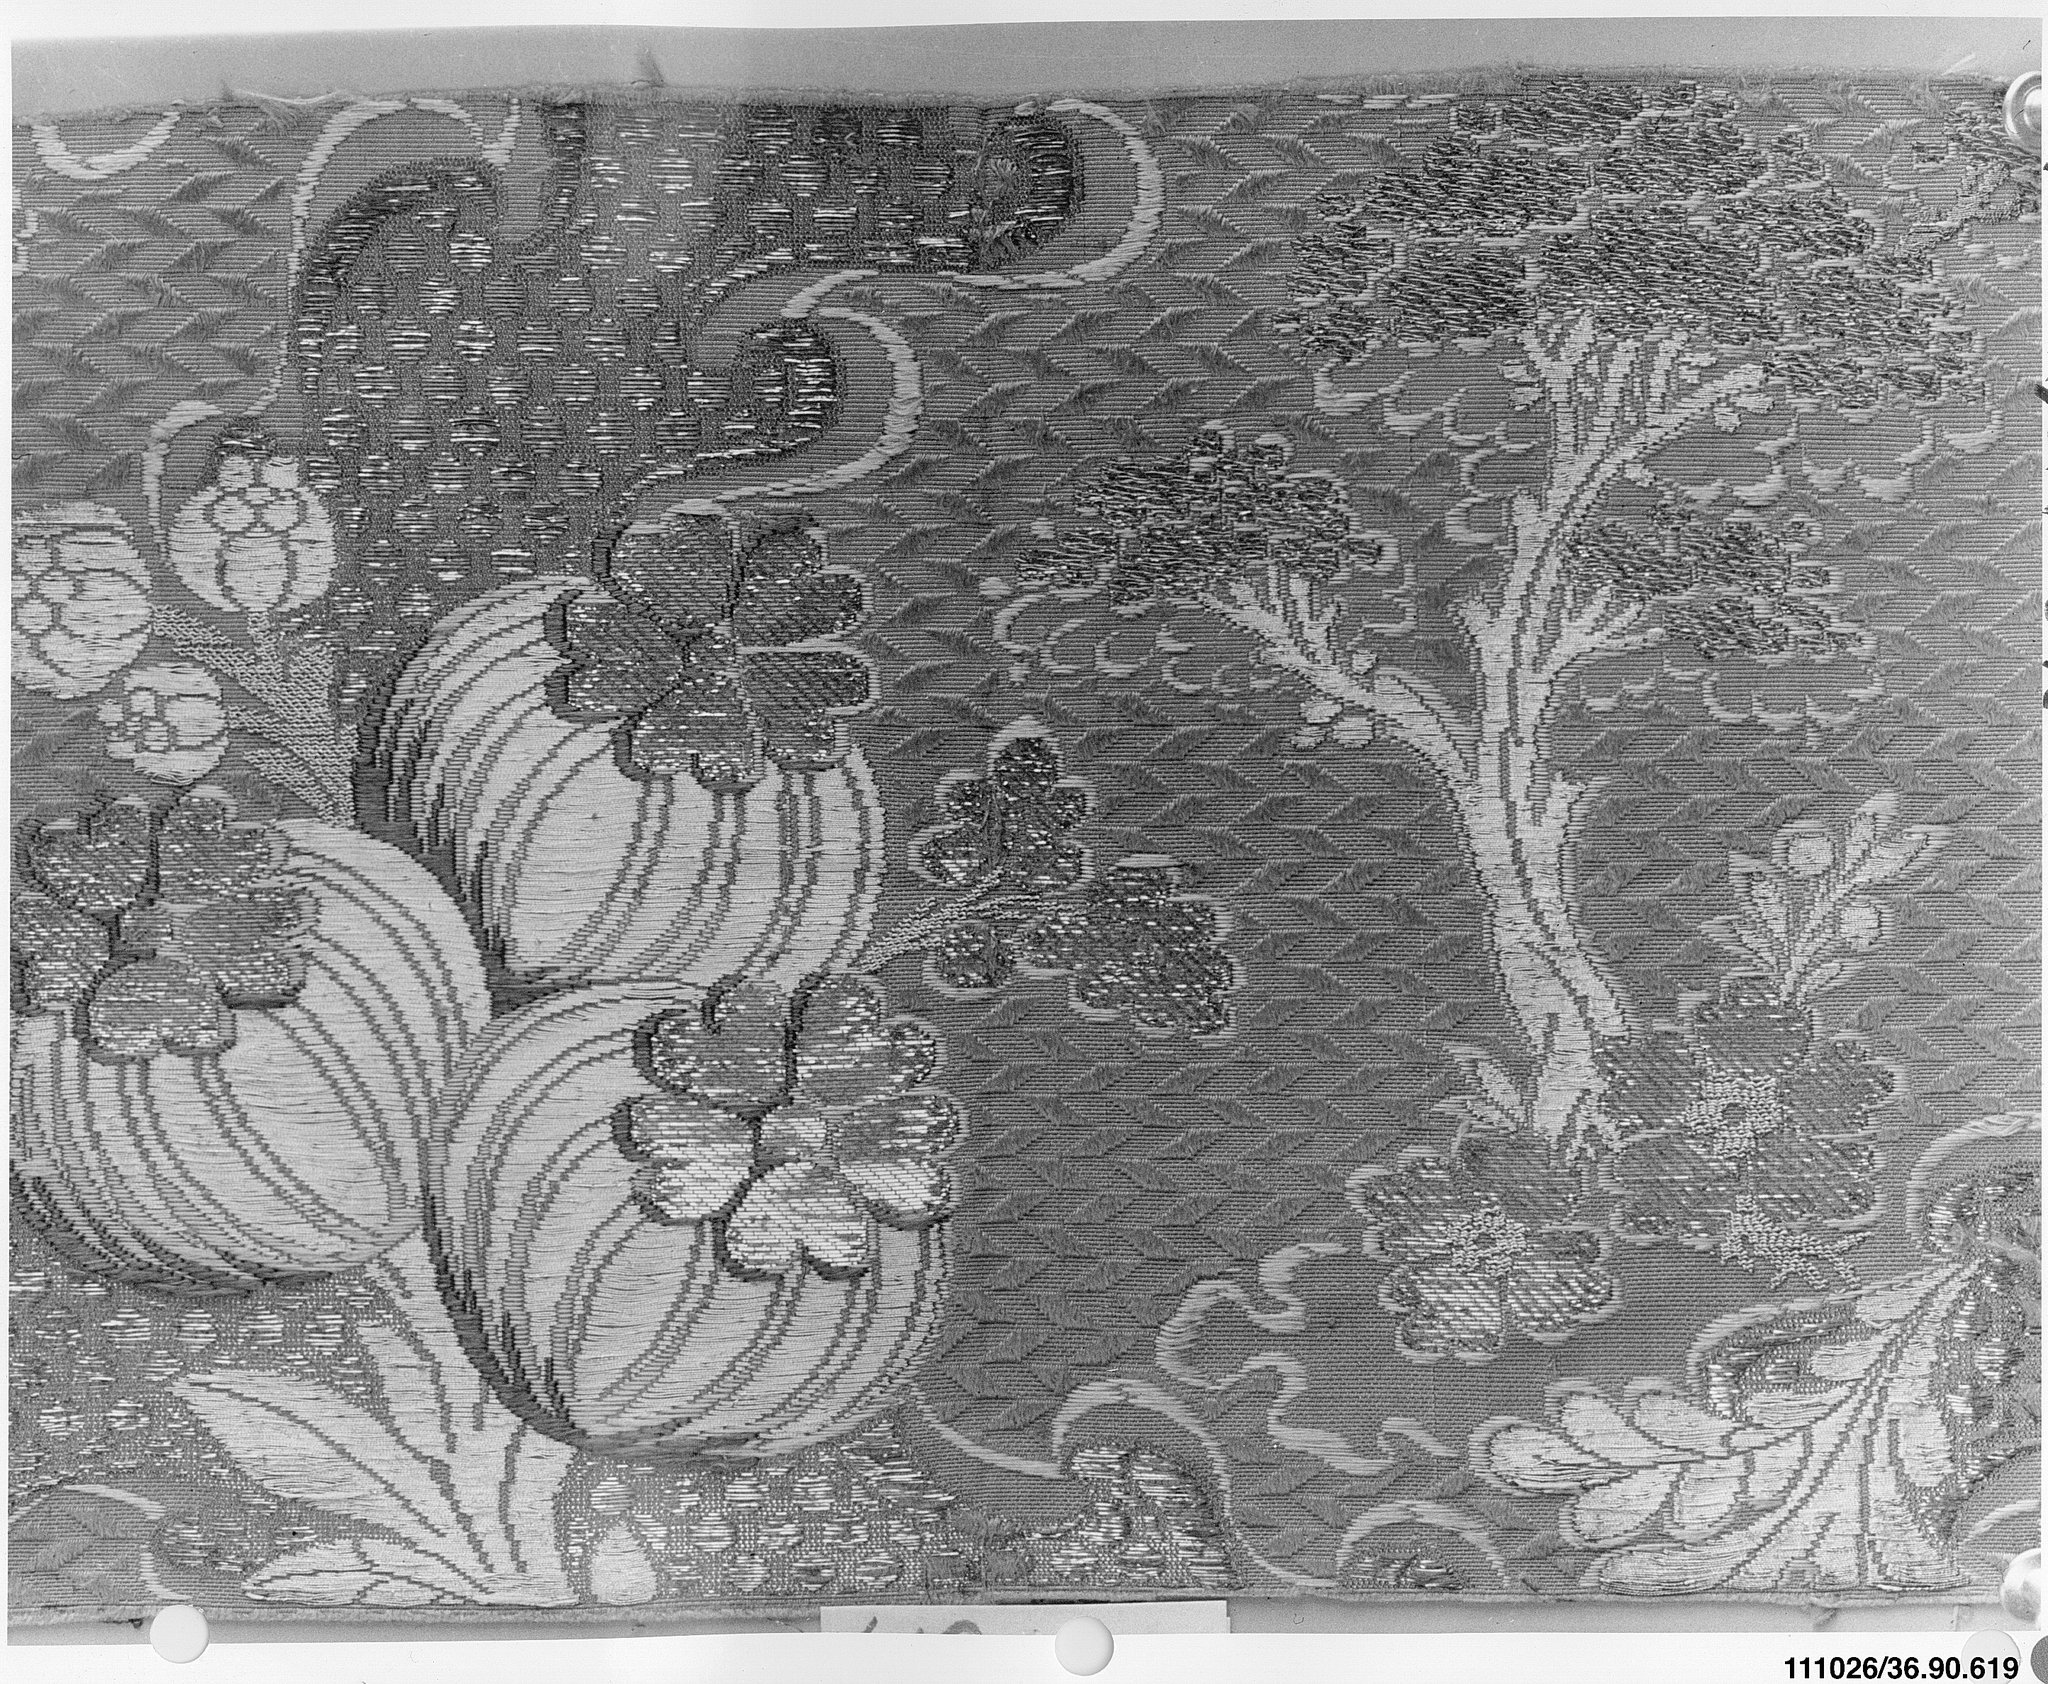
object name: piece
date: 1701-1733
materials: metal thread, silk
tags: flowers,trees